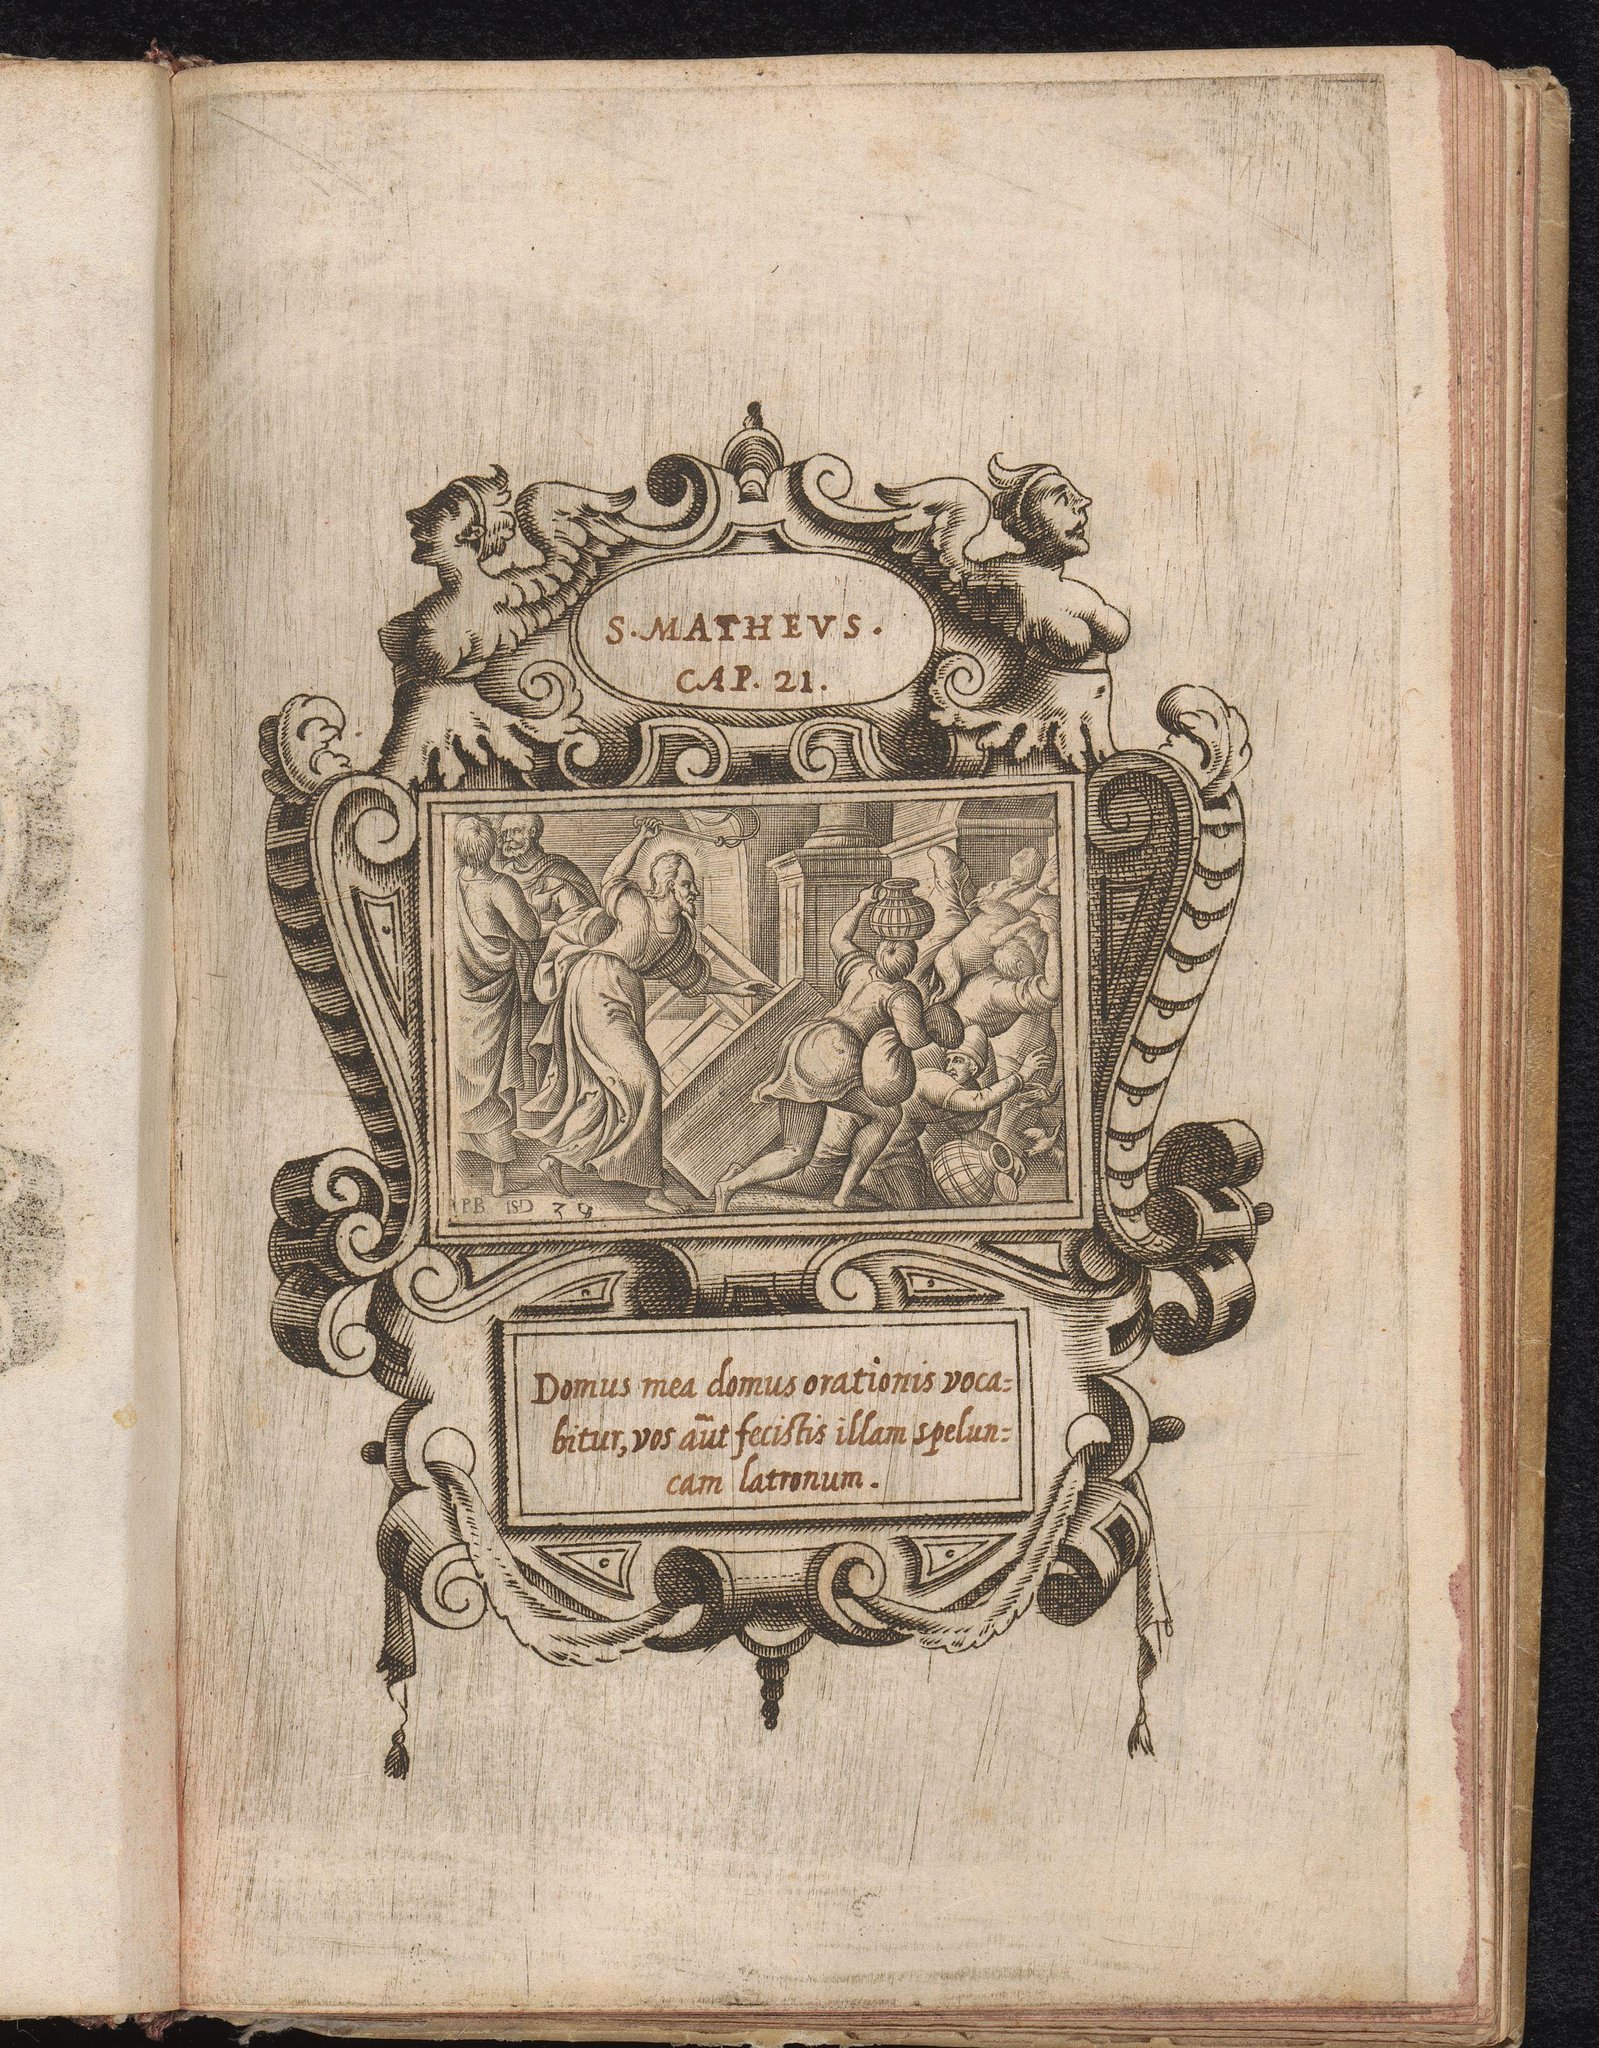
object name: print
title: Het leven van Christus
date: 1570-1610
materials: paper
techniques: engraving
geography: antwerp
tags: purification of the temple ('first' and 'second'): christ driving the money-changers from the temple with a whip (matthew 21:12-13; mark 11:15-17; luke 19:45-46; john 12:12-19)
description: Christus verdrijft de geldwisselaars uit de tempel. Onderdeel van een prentalbum met titelprent en 56 scènes uit het Nieuwe Testament. Elke voorstelling gemonteerd in een gravure met ornamentele cartouches waarin een venster is gesneden en voorzien van handgeschreven bijbelpassages.